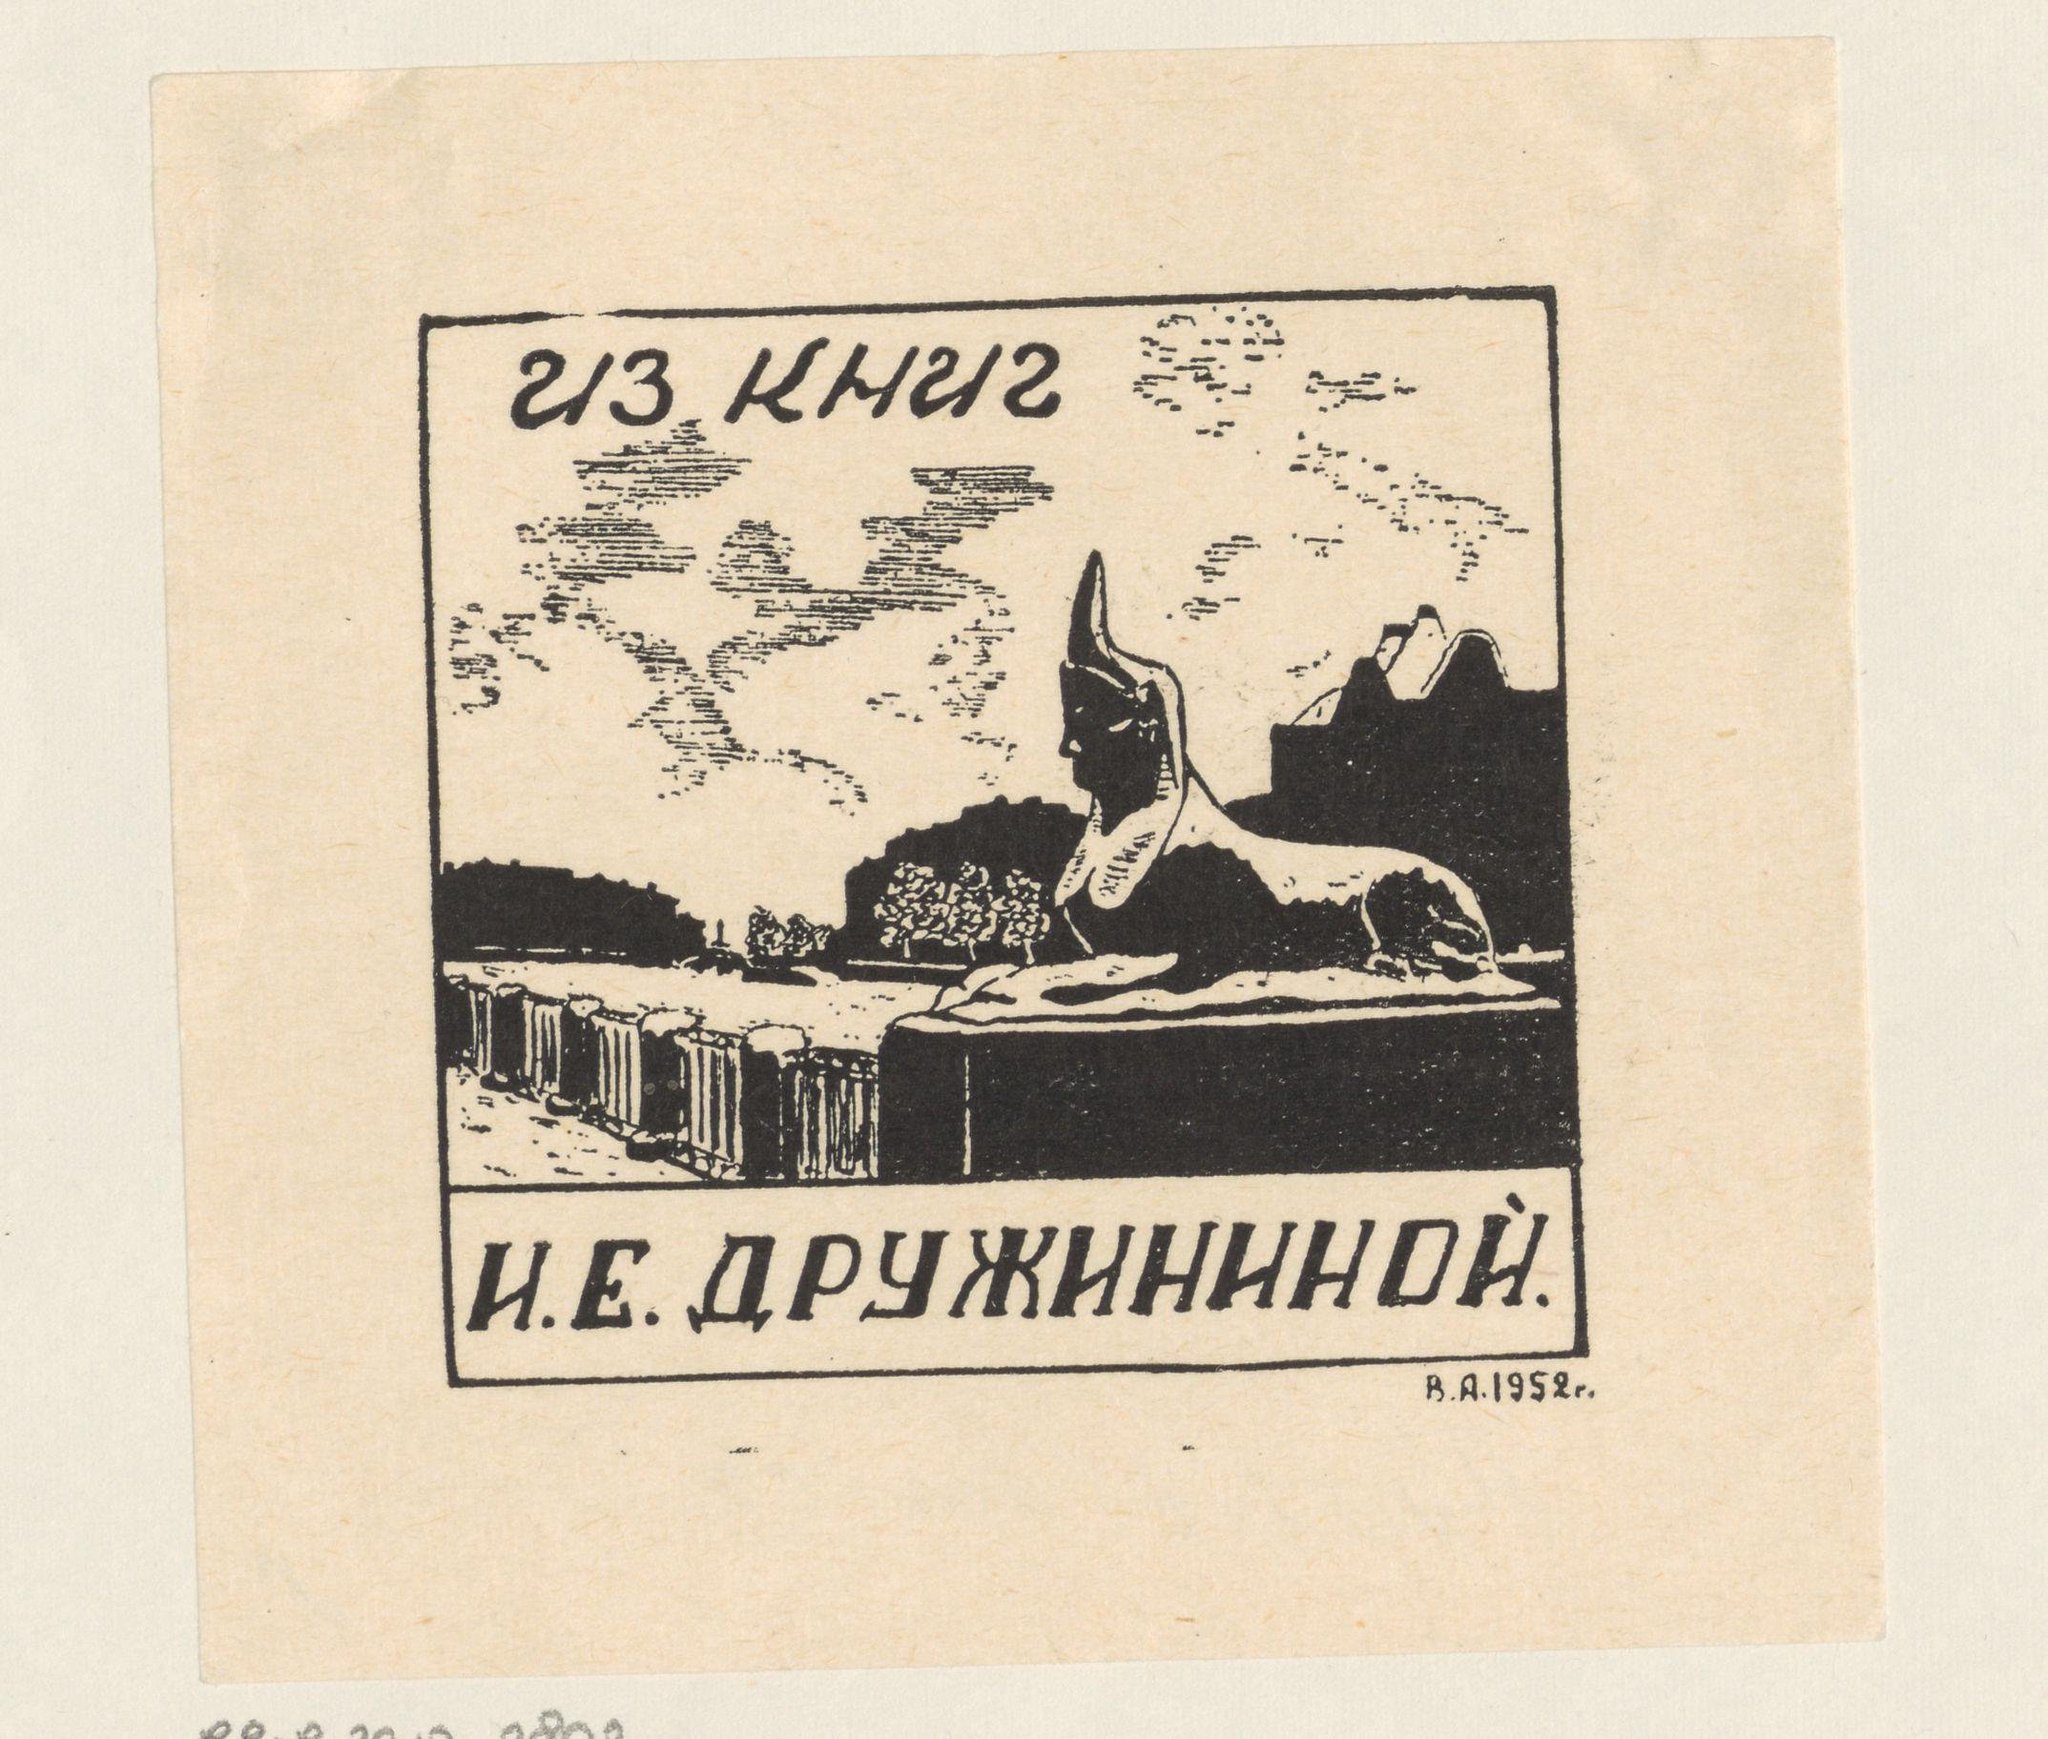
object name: bookplate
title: Ex libris van И.Е. Дружининой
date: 1952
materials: paper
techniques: printing block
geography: ukraine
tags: sphinx (lion/woman); 'sfinge' (ripa) - aa - female human figure, fence, wall, paling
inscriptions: date